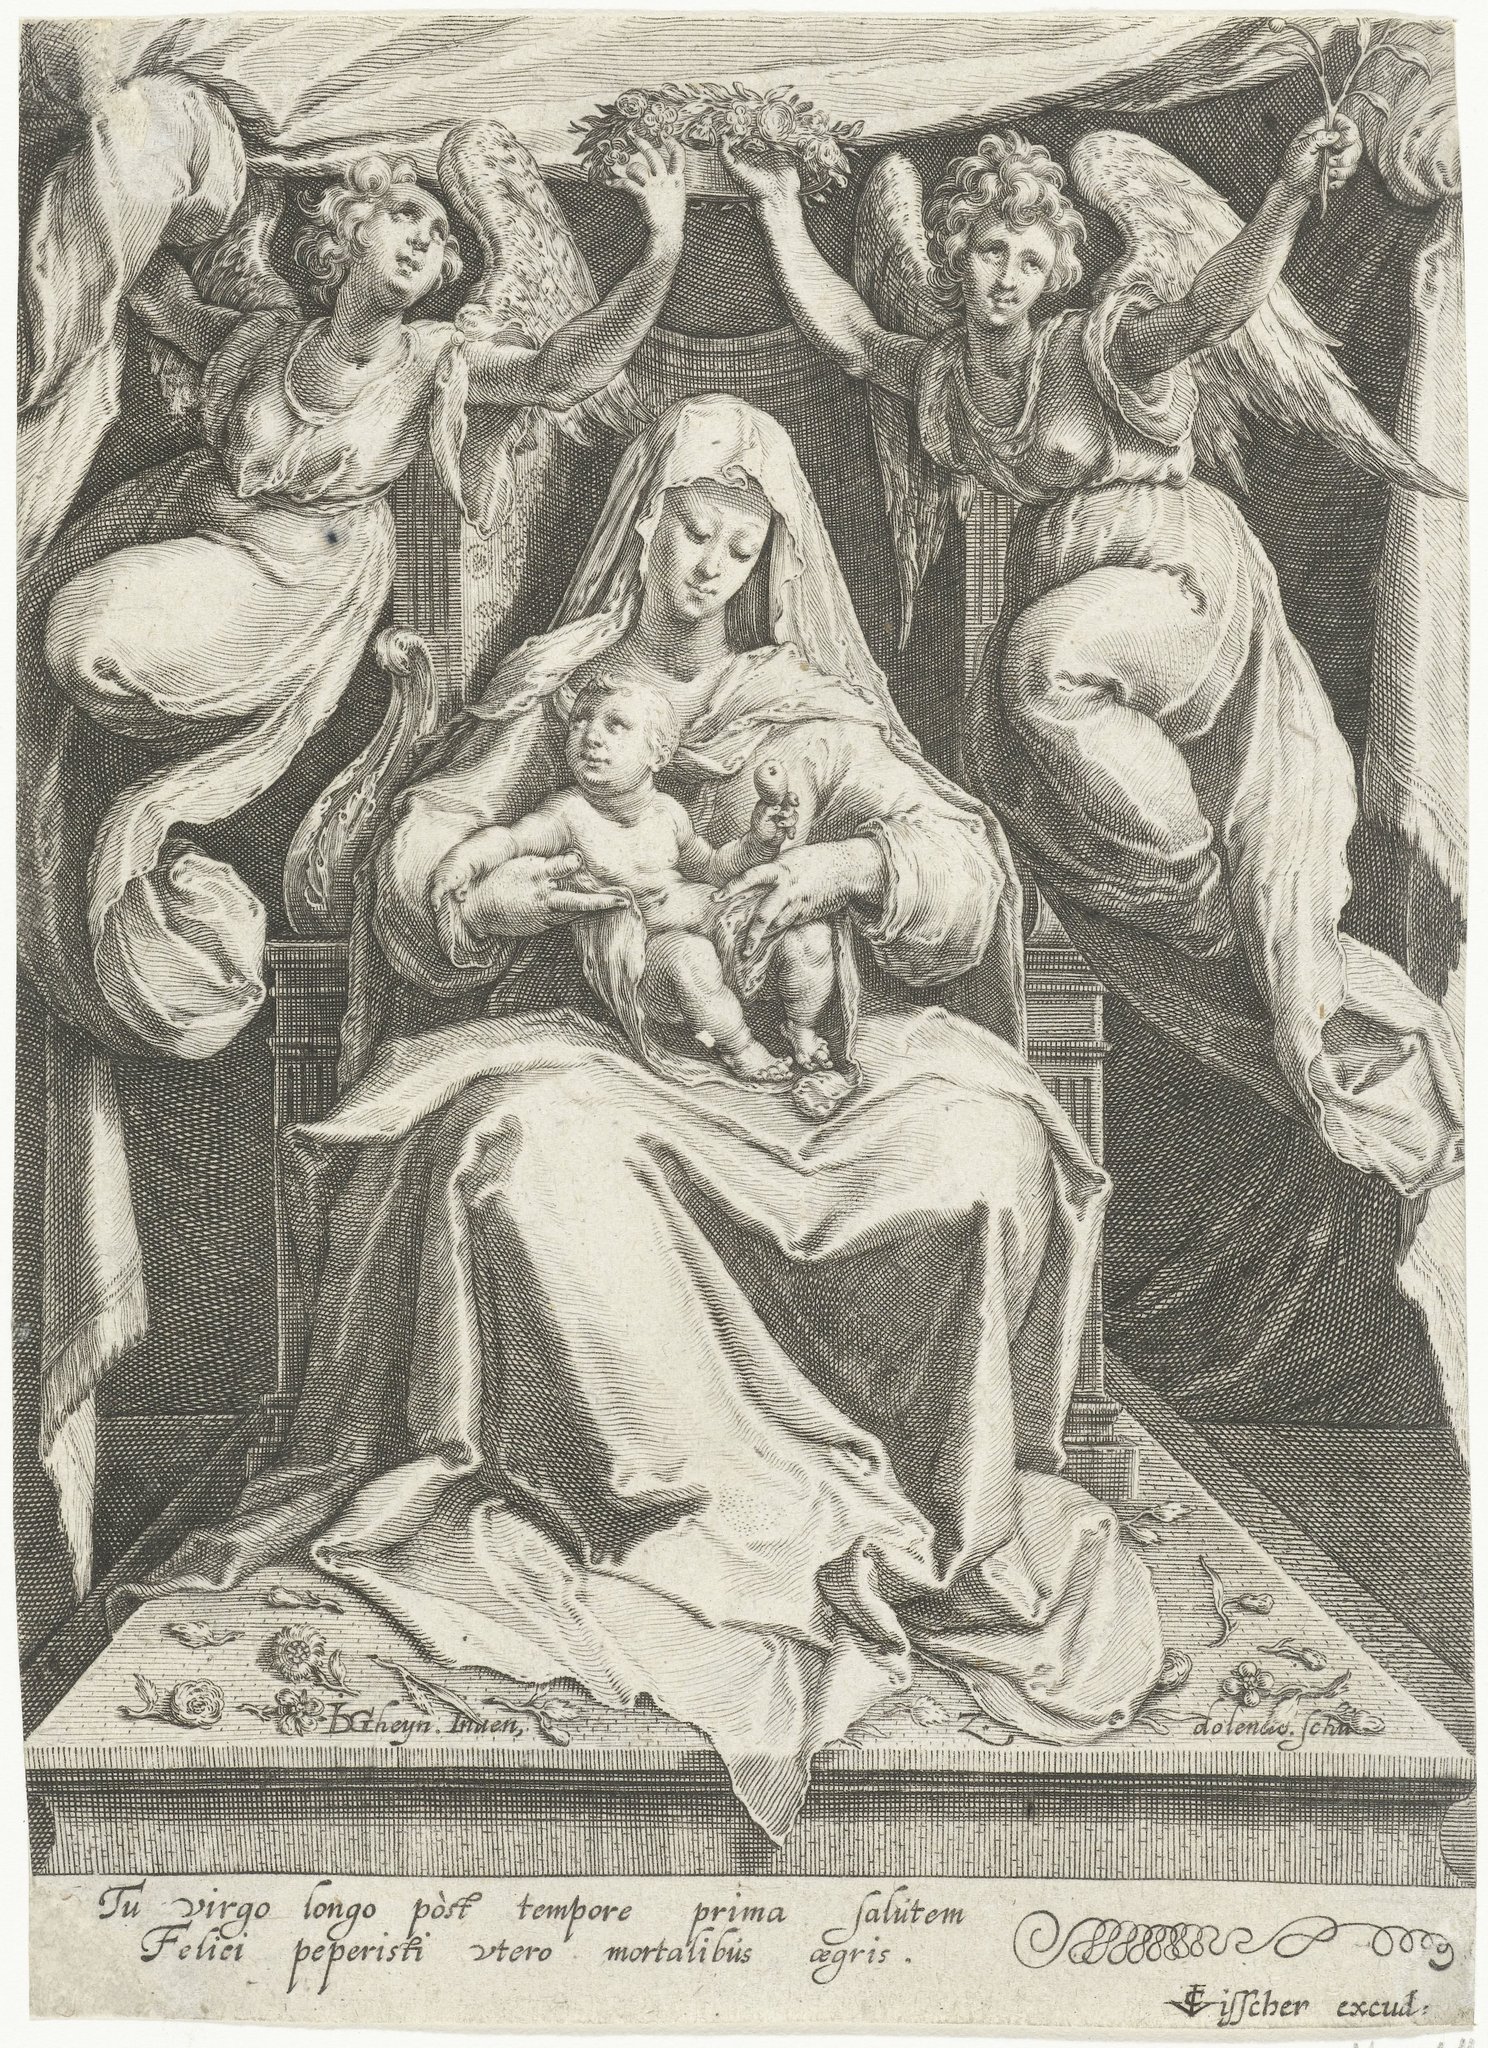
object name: print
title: Tronende Maria met Kind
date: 1595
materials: paper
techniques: engraving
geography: amsterdam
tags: mary sitting or enthroned, the christ-child in front of her in her lap (or in front of her bosom) (+ angel(s))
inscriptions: collector's mark: Lugt 2228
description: Maria zit op een troon, het Kind in haar schoot. Twee engelen houden een bloemenkrans boven haar hoofd. Op het bodes waarop haar troon staat liggen strooibloemen. Onder de voorstelling een Latijns vers.